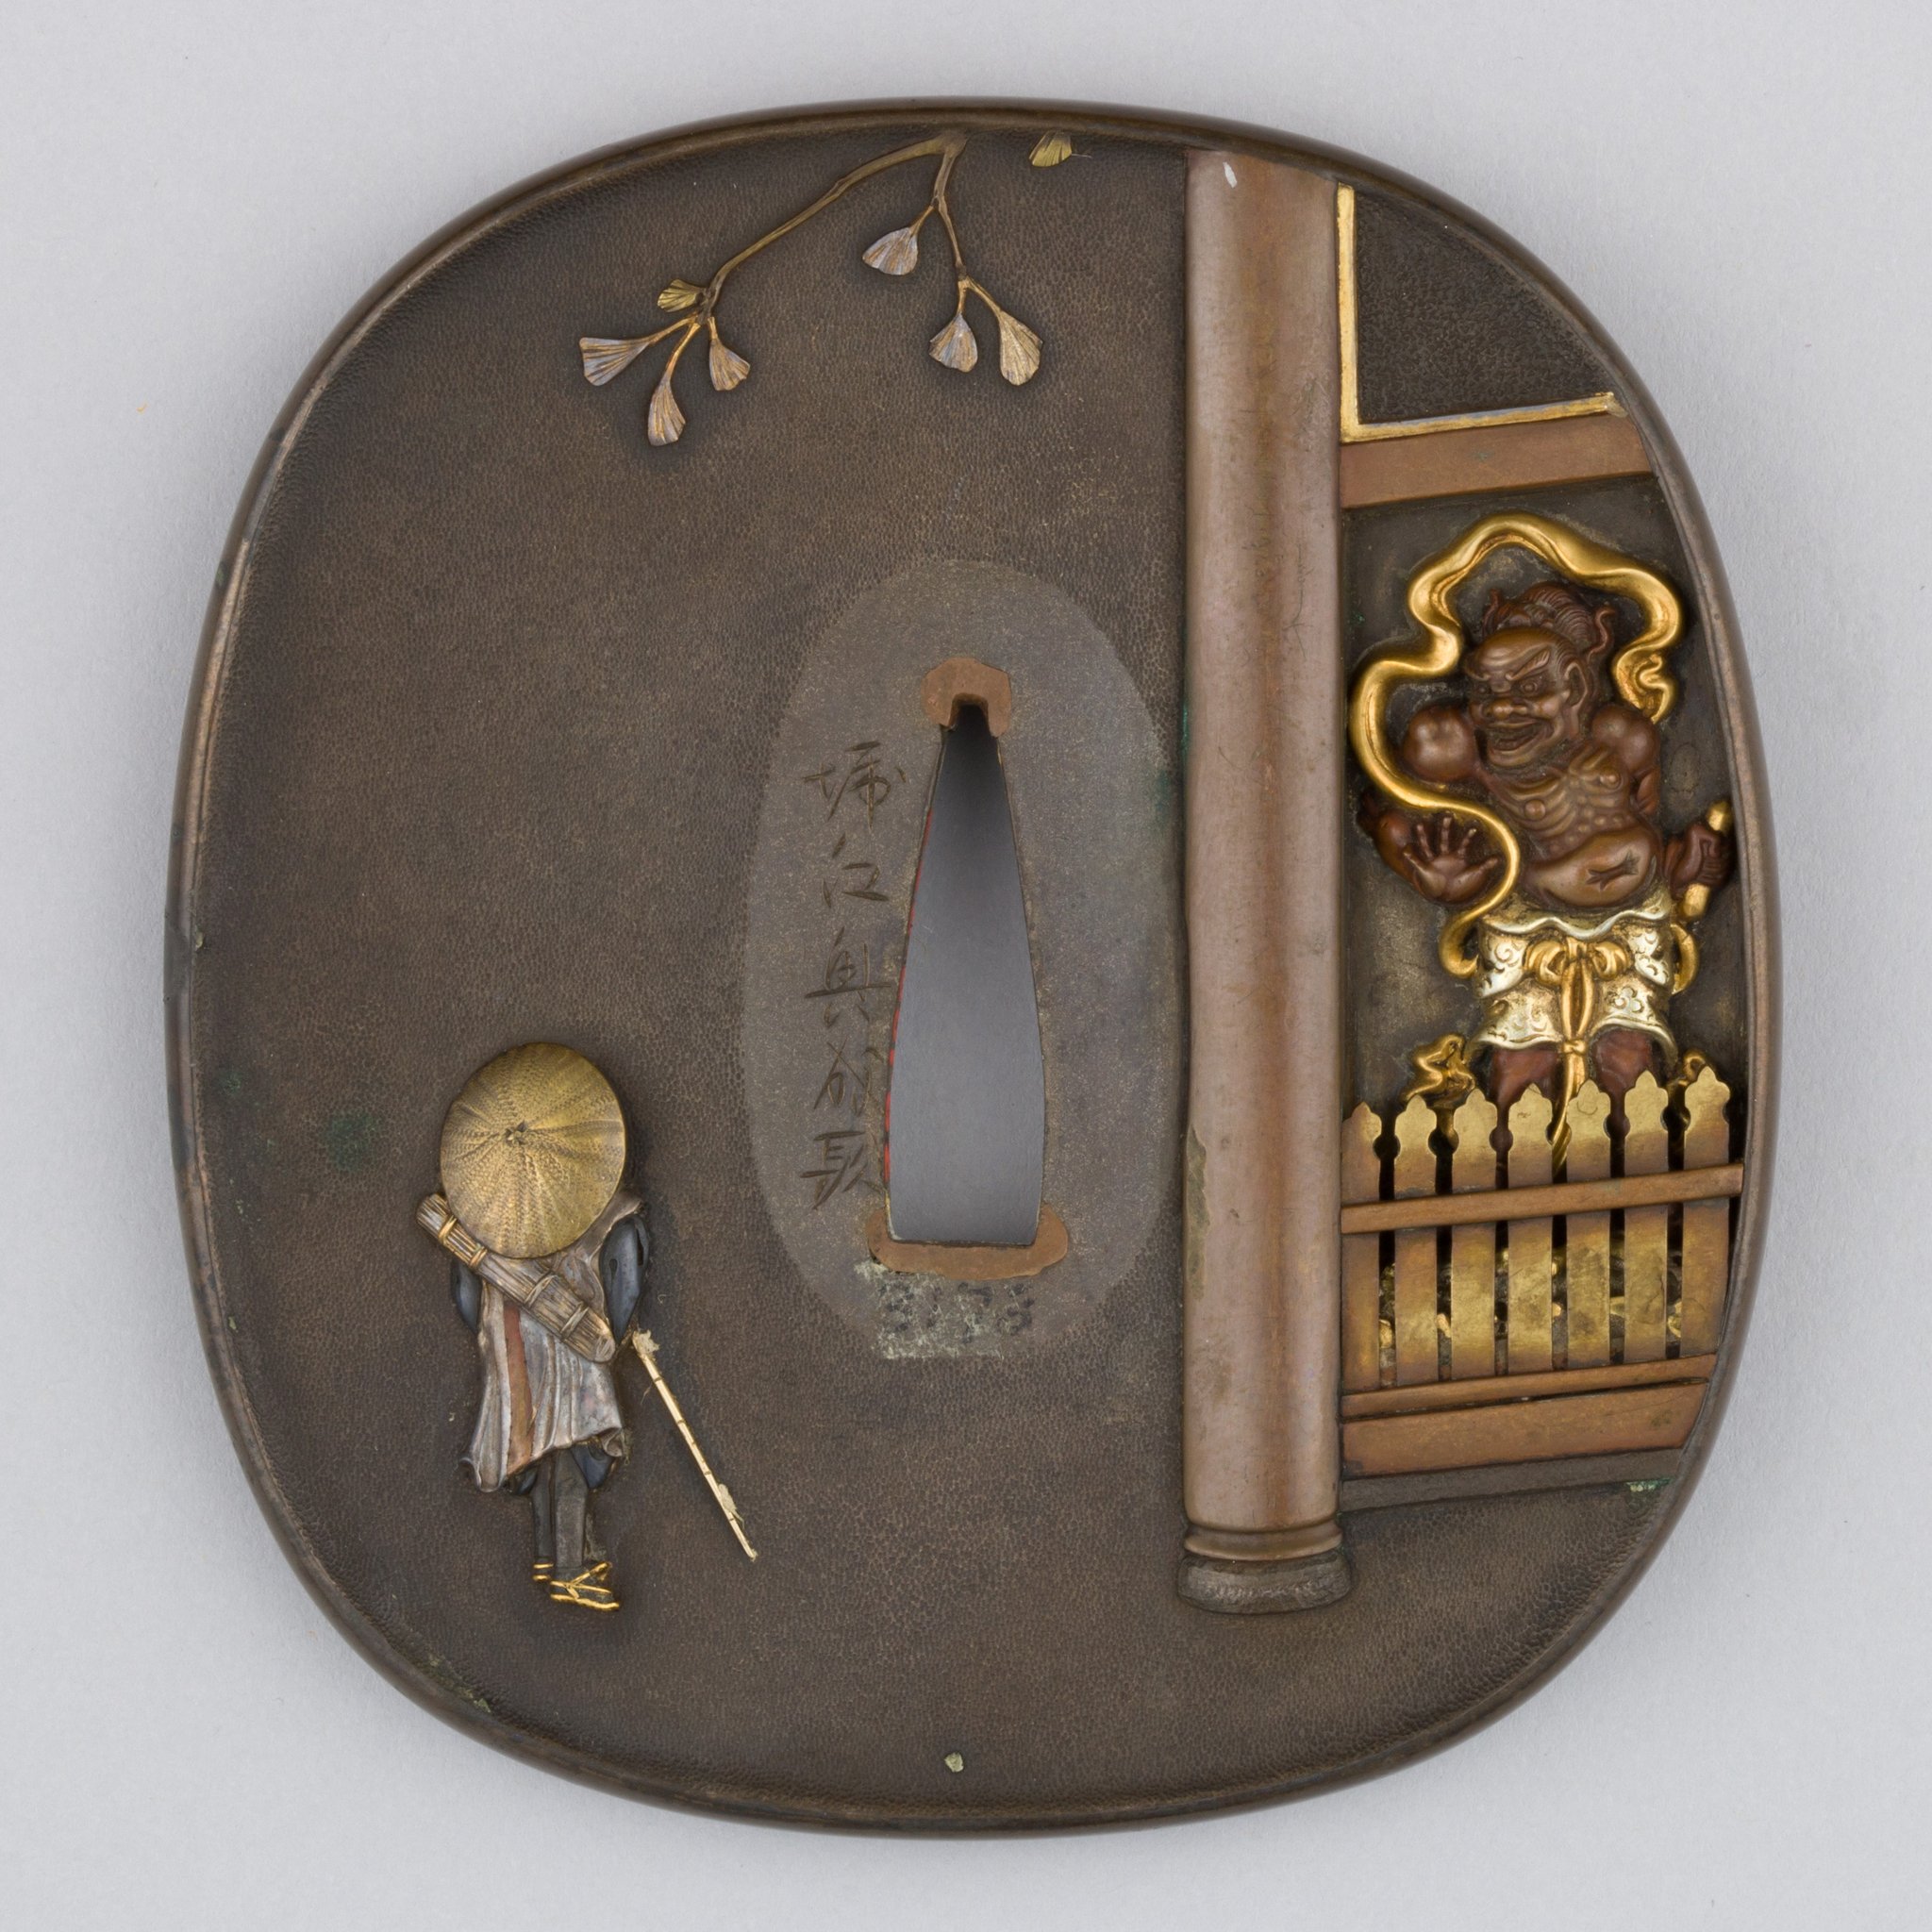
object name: sword guard tsuba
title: Sword Guard (Tsuba)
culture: japanese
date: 1615-1868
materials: copper, copper alloy, gold alloy, silver alloy, gold, silver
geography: japan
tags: men